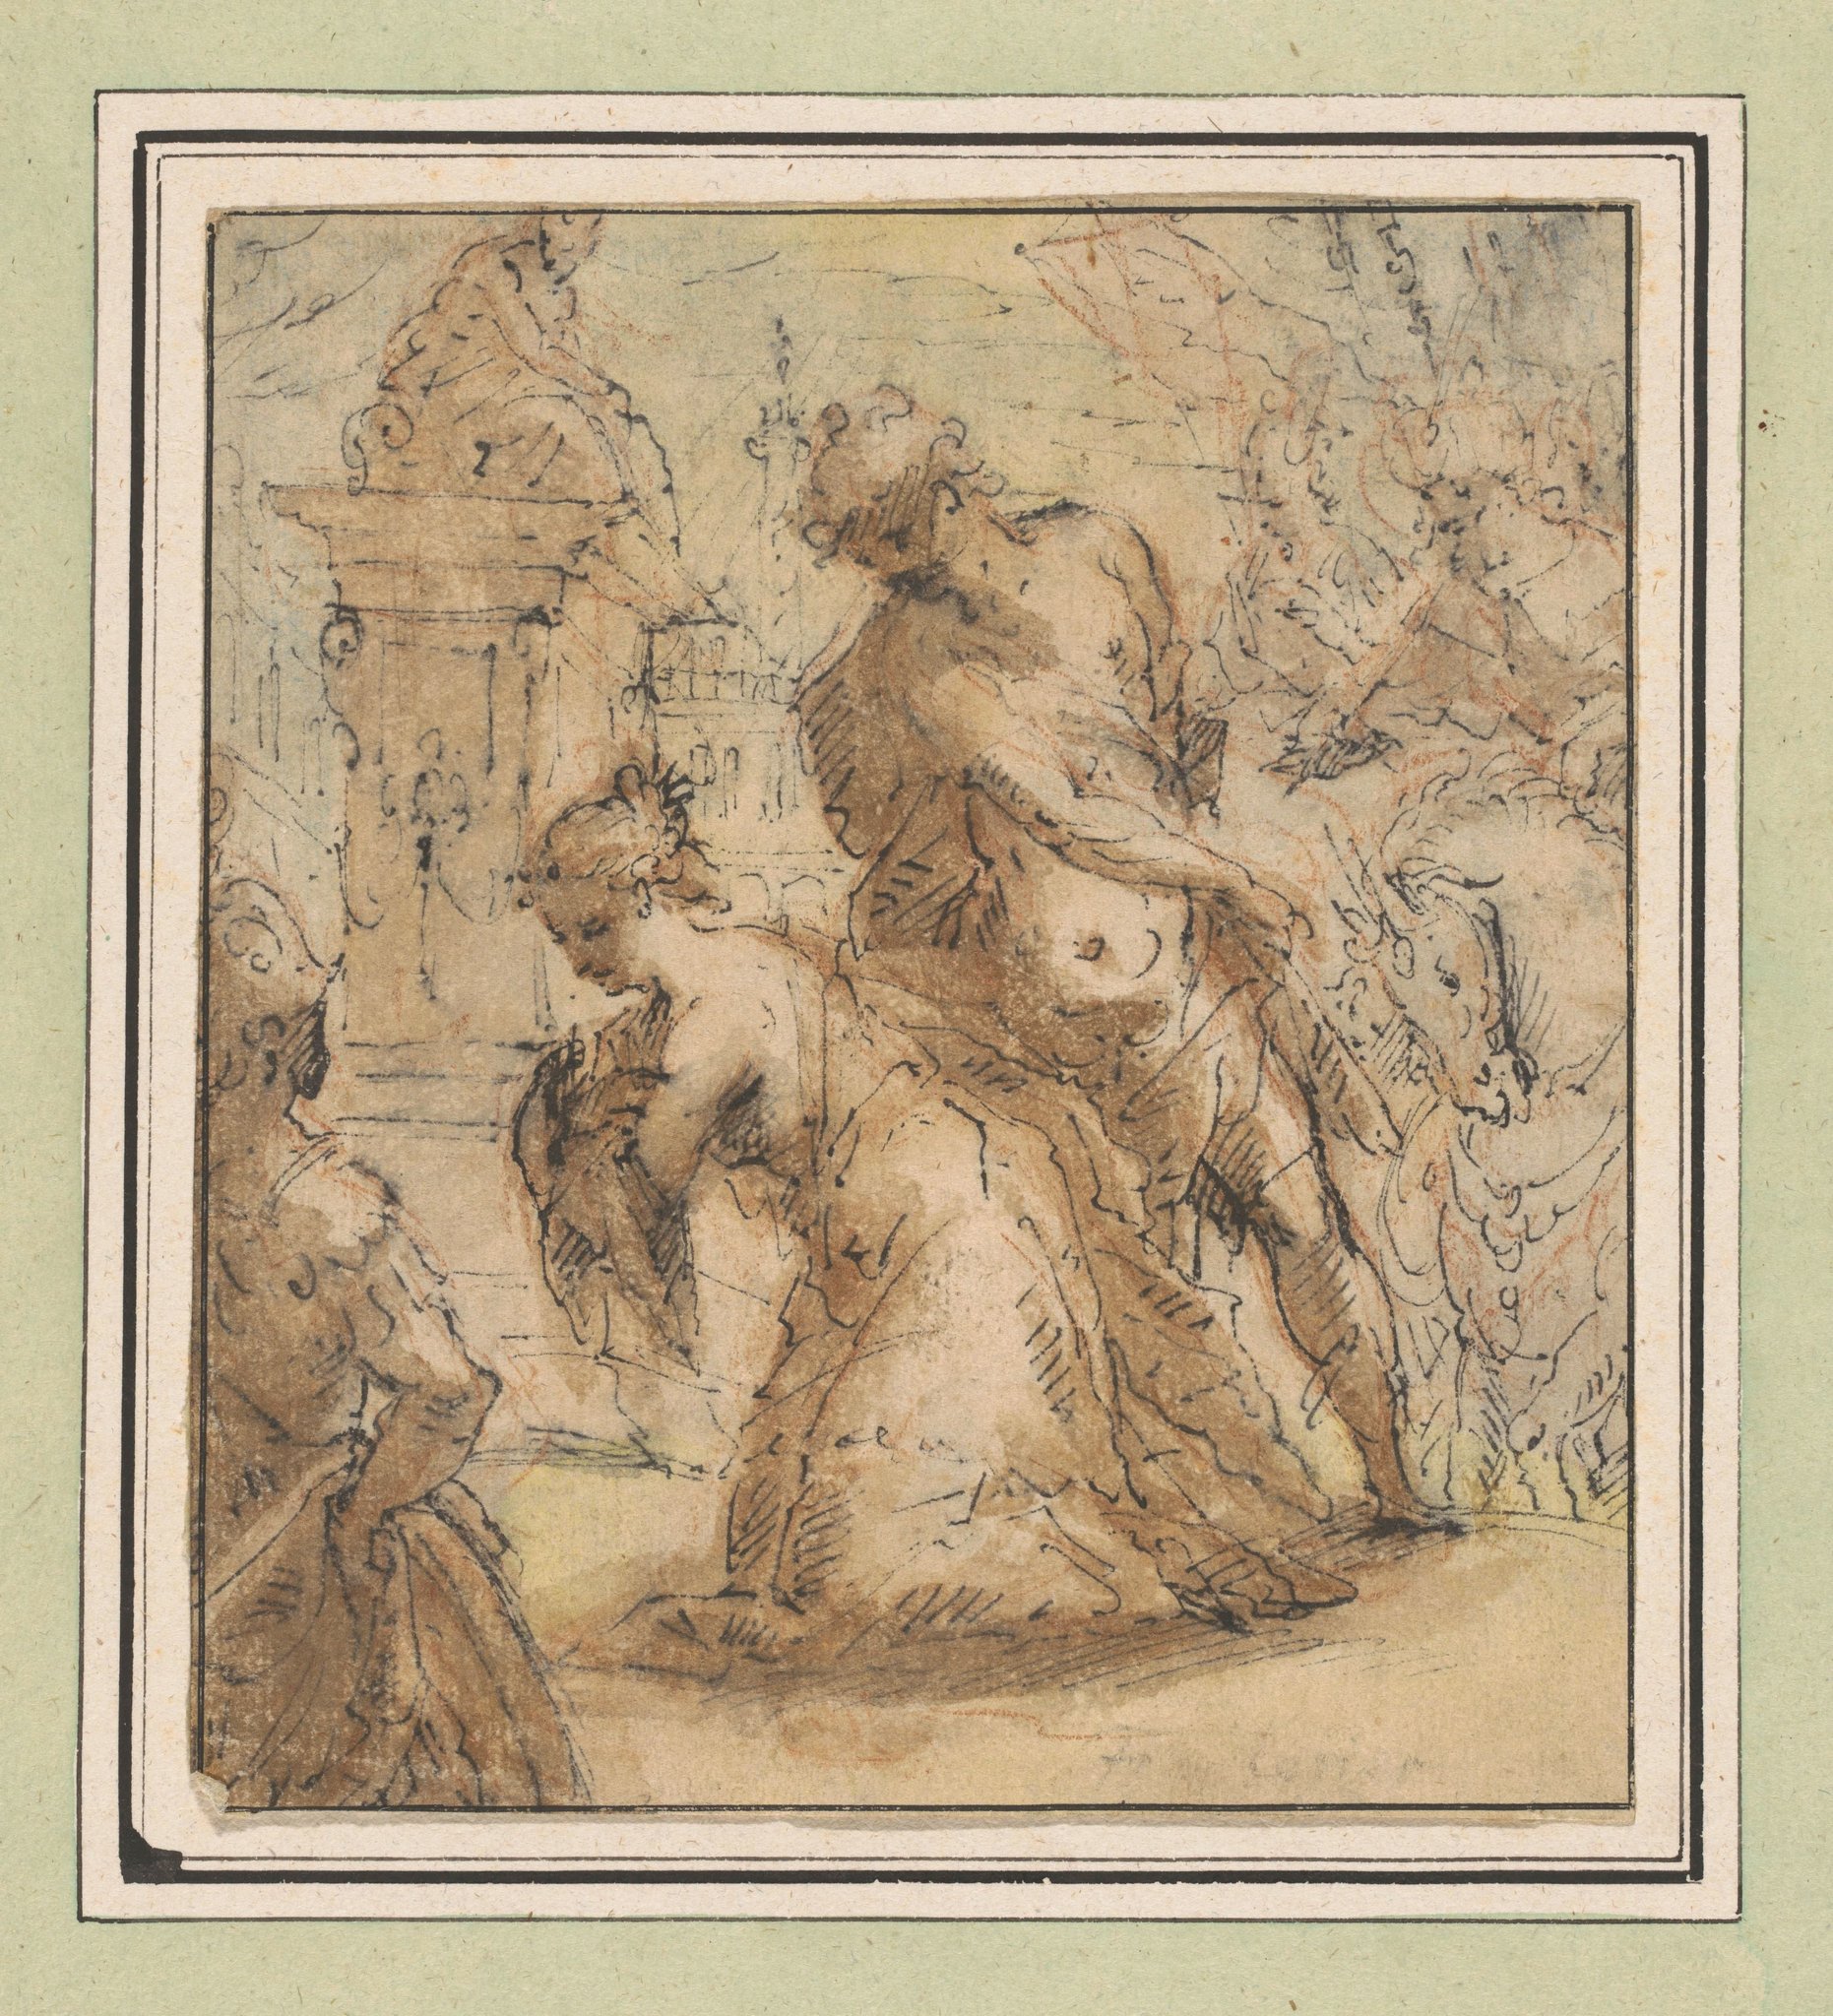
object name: drawing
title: Onthoofding van een heilige (H. Catharina?)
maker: françois perrier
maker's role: draughtsman, painter, print maker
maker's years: 1594-1649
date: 1600-1650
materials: chalk, ink, paper, watercolor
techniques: brush, pen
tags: st. catherine of alexandria is beheaded, violent death by beheading